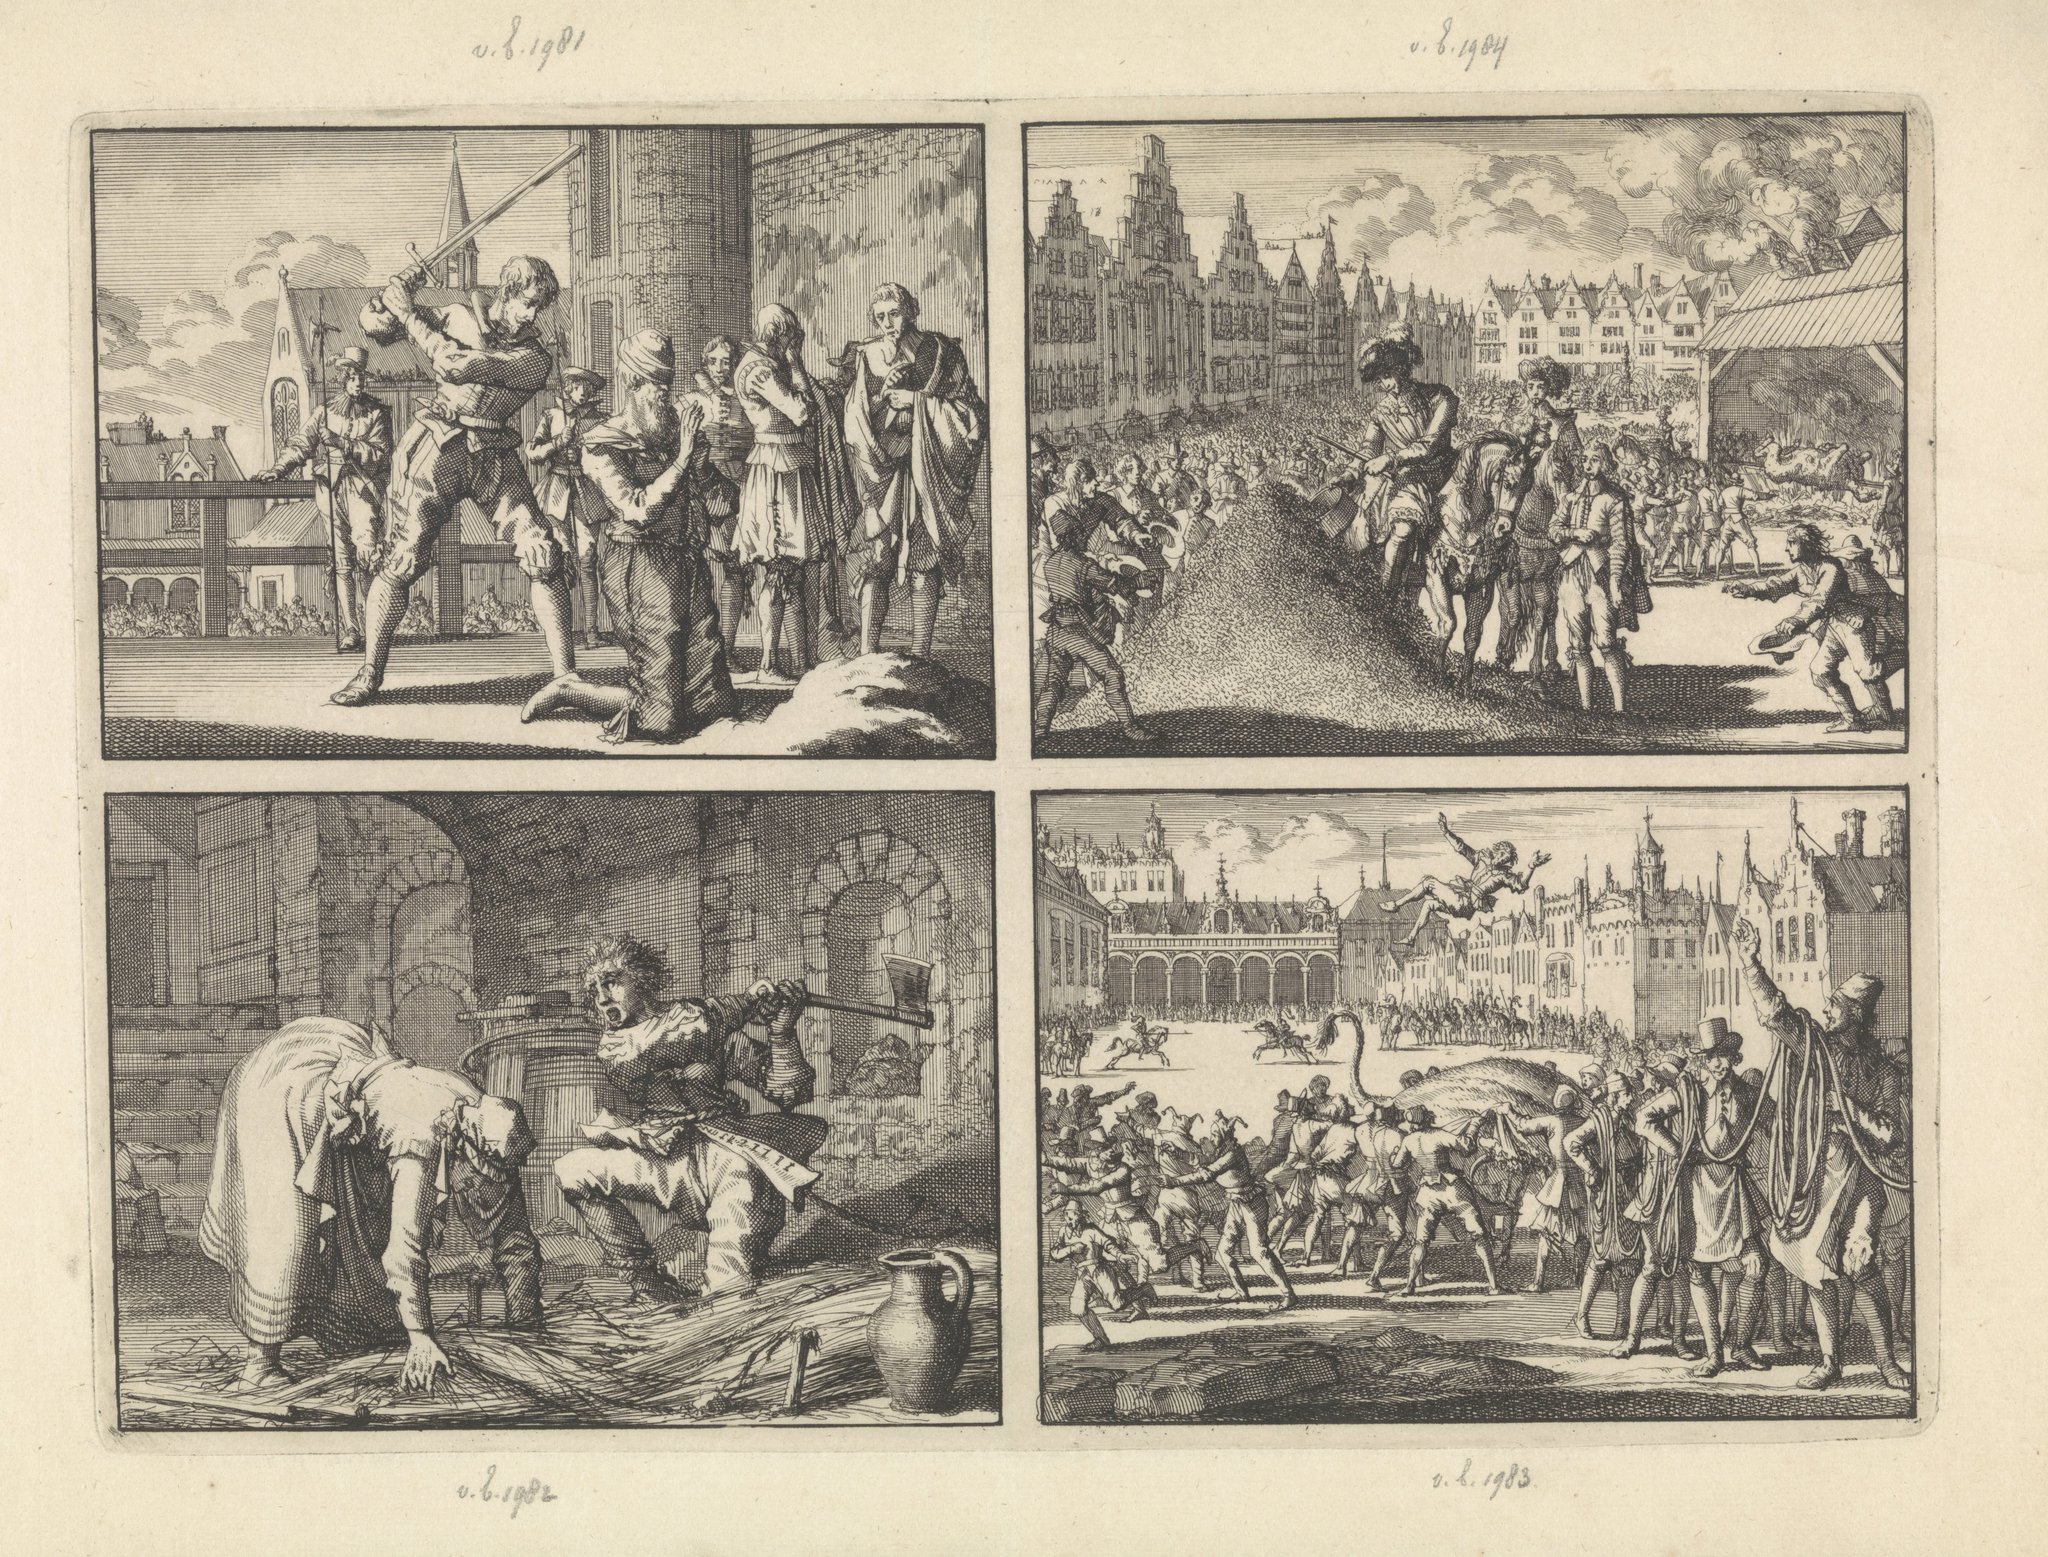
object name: print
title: Johan van Oldenbarnevelt onthoofd, 1619 / Grote Markt te Frankfurt am Main tijdens de kroning van keizer Ferdinand II, 1619 / Man te Grosz-Gerau doodt zijn moeder met een bijl terwijl zij in de kelder een strobed maakt, 1616 / Boerenbruiloft door de vleeshouwers te Wenen voor keizer Matthias, 1613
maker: jan luyken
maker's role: draughtsman, print maker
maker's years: 1649-1712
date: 1698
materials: paper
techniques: etching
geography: amsterdam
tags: johan van oldenbarnevelt, matthias van oostenrijk (rooms-duits keizer), ferdinand ii (duits keizer), coronation of a ruler, tools, aids, implements ~ crafts and industries: axe, murder, violent death by beheading, vienna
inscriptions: collector's mark: Lugt 2228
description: Prenten gebruikt als illustratie in: Gottfried, Johann Ludwig. Historische kronyck; vervattende een (...) beschrijvingh der aldergedenckwaerdigste geschiedenissen des weerelds, van den aenvangh der scheppingh tot (...) 1576 (2 delen). Leiden: Pieter van der Aa, 1698, dl. I, p. 863, 931, 879, 891.